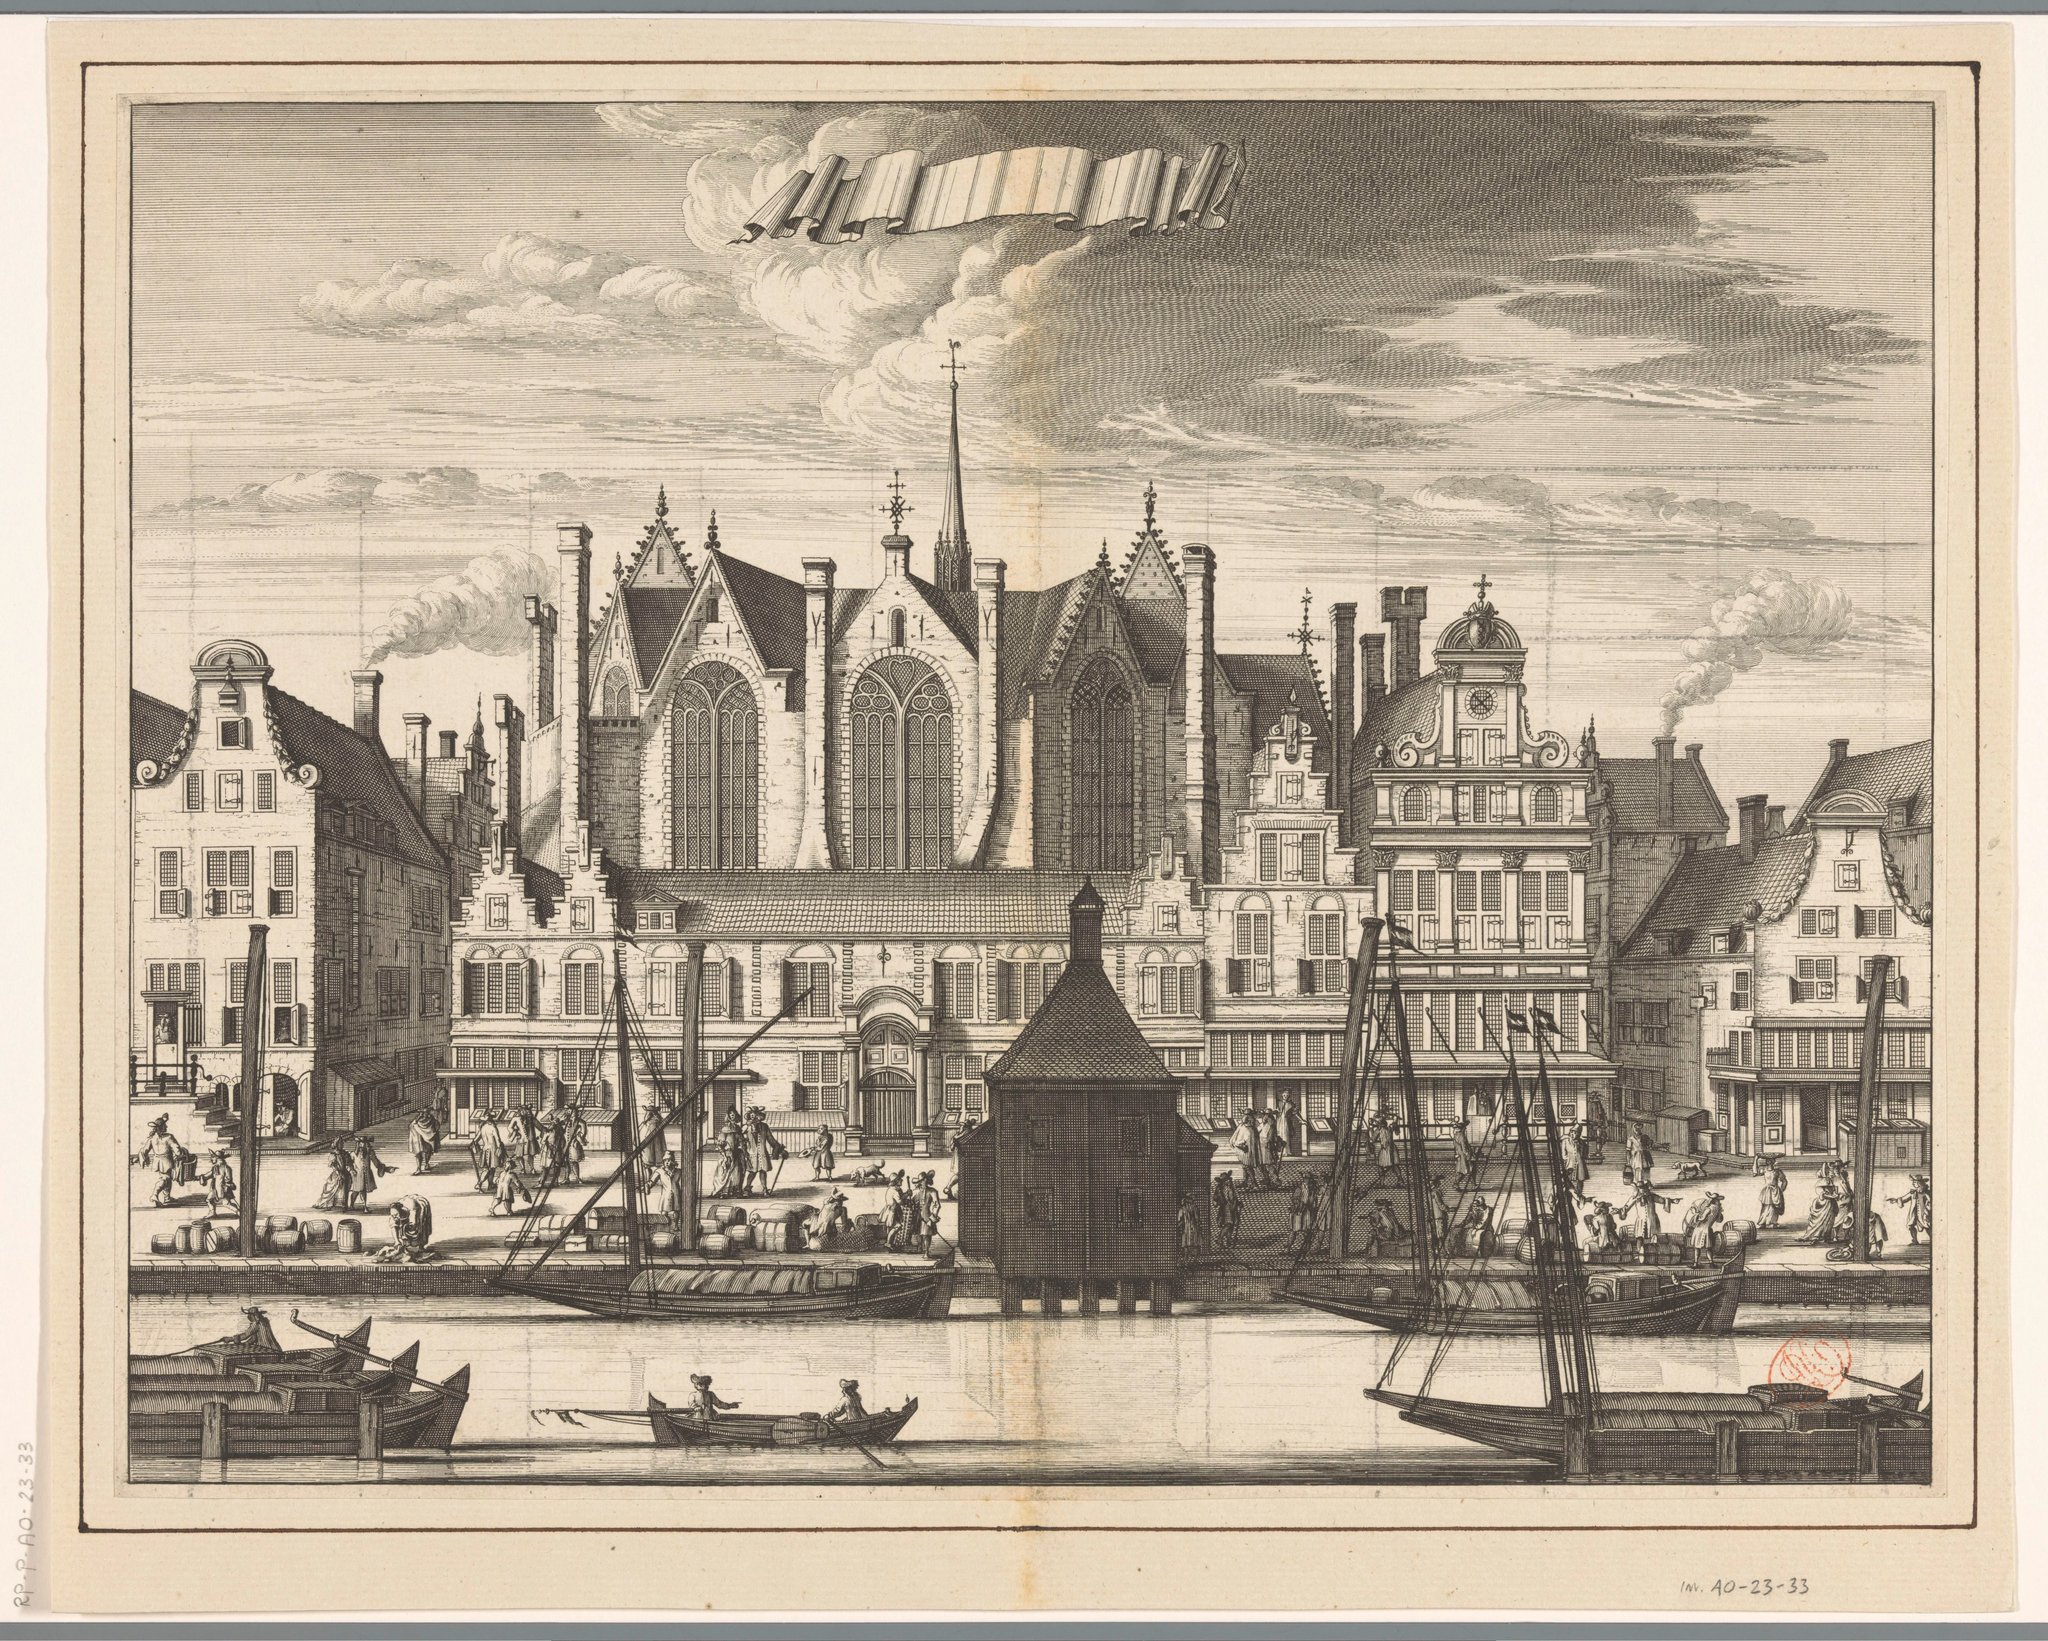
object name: print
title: Gezicht op de Nieuwezijds Kapel te Amsterdam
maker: Anonymous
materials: paper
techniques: engraving, etching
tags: church (exterior) - qq - small church, chapel, street (+ city(-scape) with figures, staffage)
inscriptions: collector's mark: Lugt 195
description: Tweede bekende staat van prent ook gebruikt in: Commelin, Caspar. Beschryvinge van Amsterdam, desselfs eerste oorspronk uyt den Huyse (…). 2 delen. Amsterdam: Abraham Wolfgang, Gillis Janssonius van Waesberge, Johannes Janssonius van Waesberge II, weduwe Dirk Boom I, Hendrick Boom en Rembertus Goethals, 1693. En in: Commelin, Caspar. Beschryvinge van Amsterdam, zynde een naukeurige verhandelinge van desselfs eerste oorspronk uyt (…). 2 delen. Amsterdam: weduwe Aart Dircksz Oossaan, 1694. Derde bekende staat van prent ook gebruikt in: Commelin, Caspar. Beschryvinge van Amsterdam, zynde een naukeurige verhandelinge van desselfs eerste oorspronk uyt (…). 2 delen. 2e druk. Amsterdam: Andries van Damme, Johannes Ratelband, weduwe A. van Aaltwyk en Hermanus Uytwerf, 1726. Zie RP-P-AO-23-34 voor tweede bekende staat.